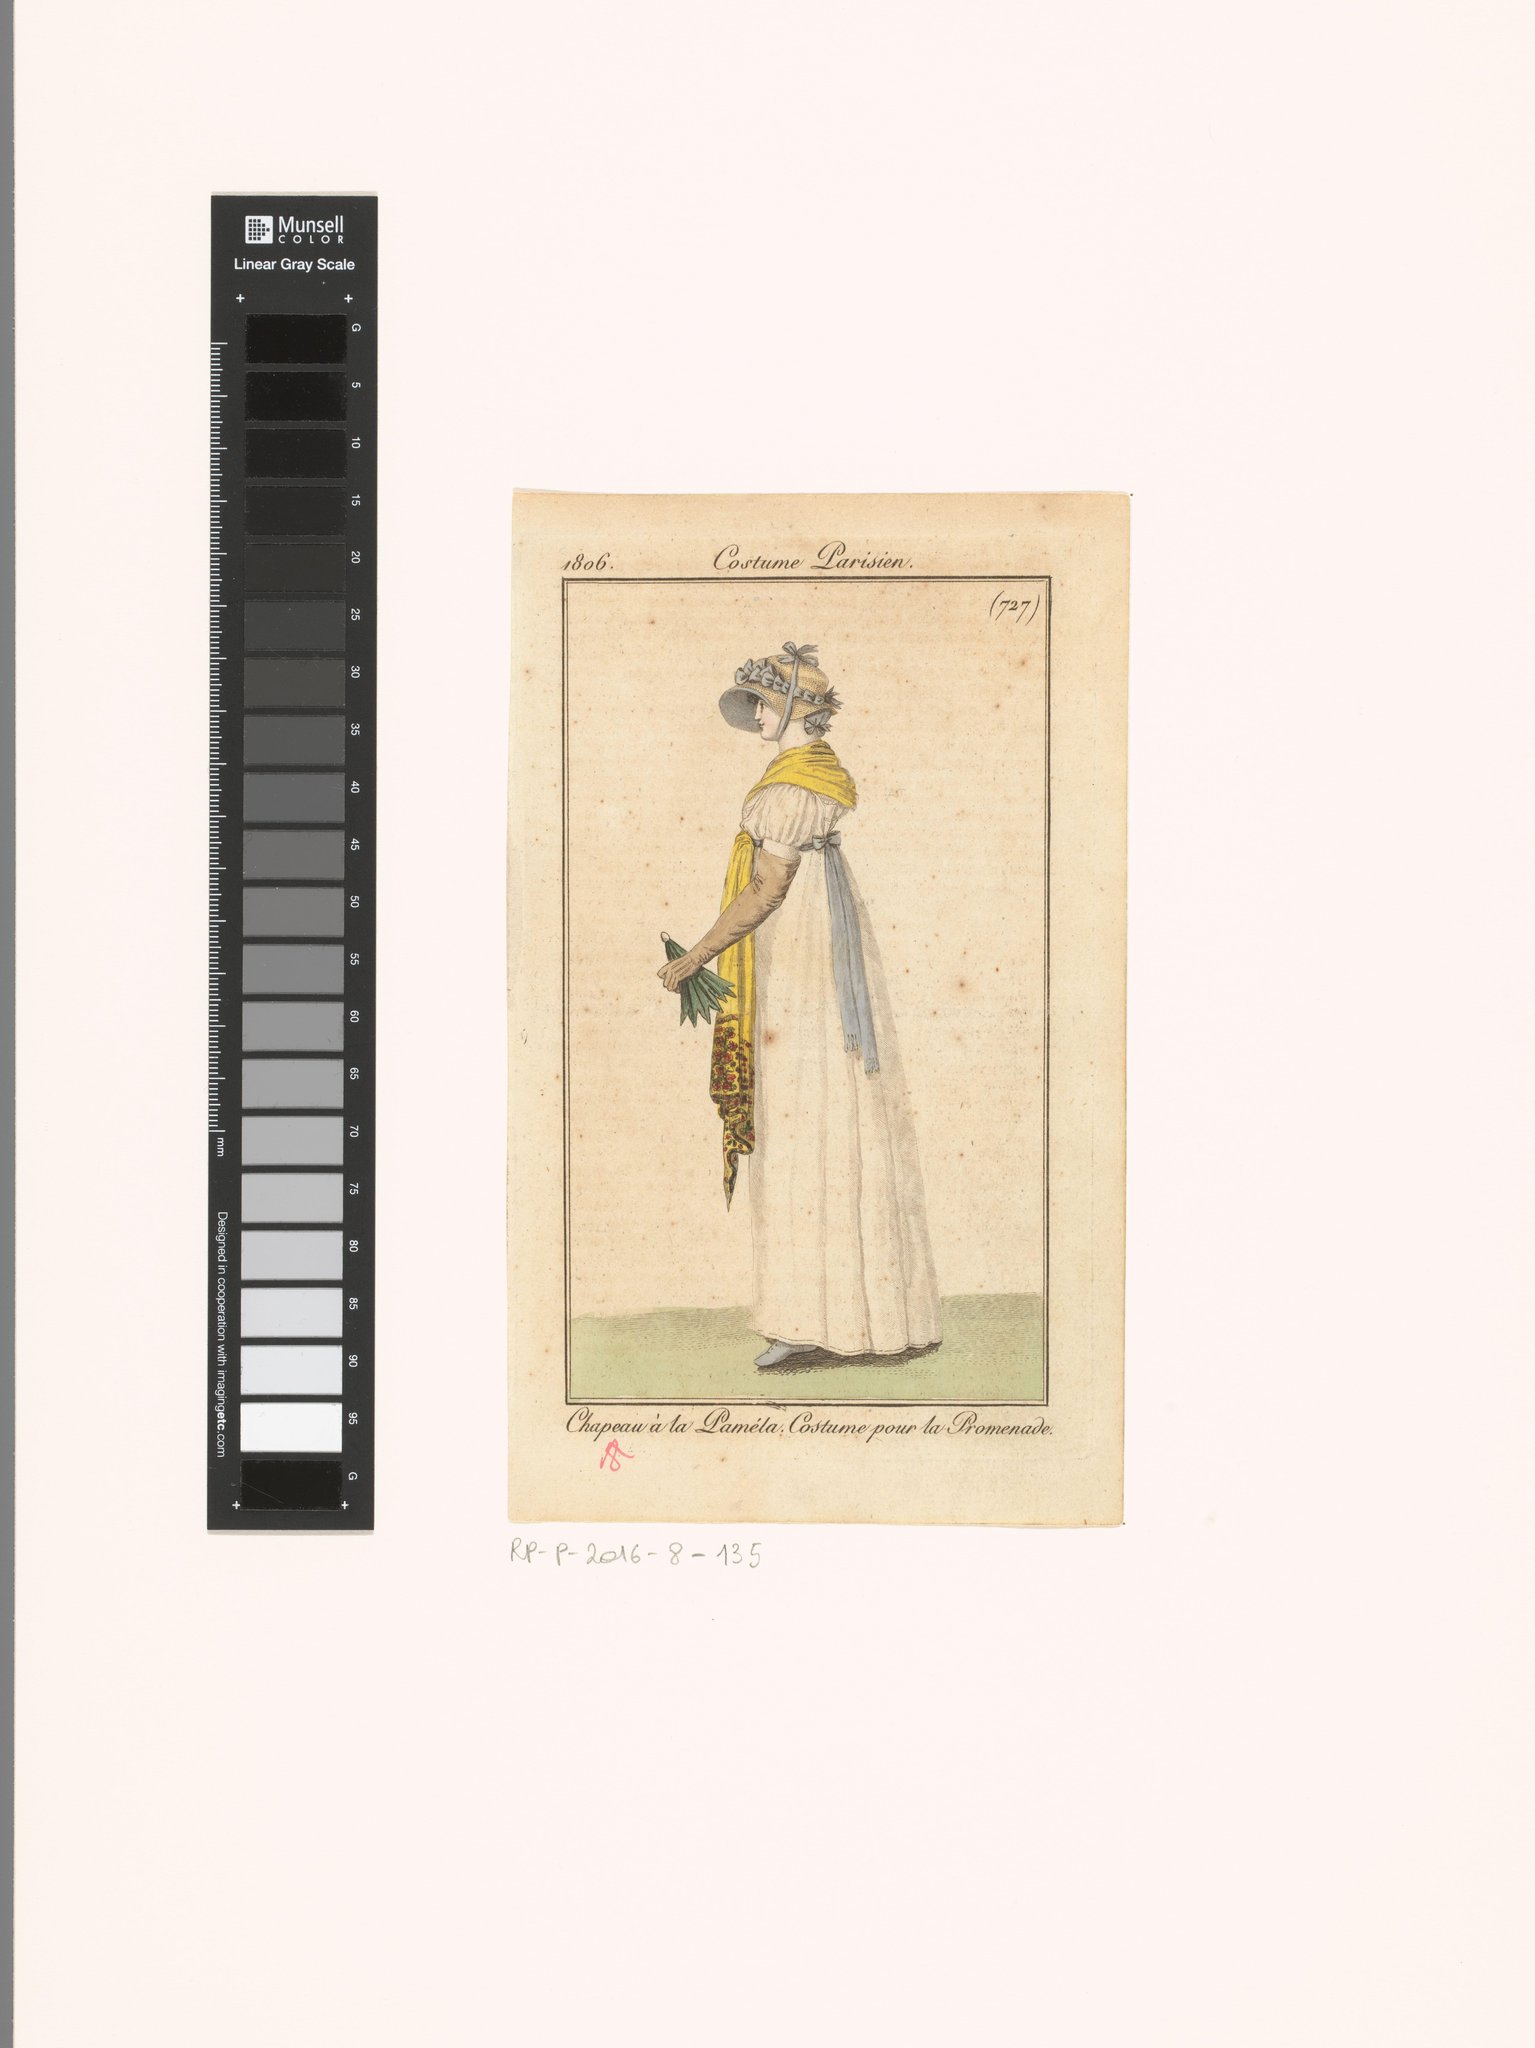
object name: fashion print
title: Journal des Dames et des modes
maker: Anonymous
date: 1806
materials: paper, ink, watercolor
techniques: etching, hand coloring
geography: france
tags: fashion plates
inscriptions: collector's mark: Lugt 2228